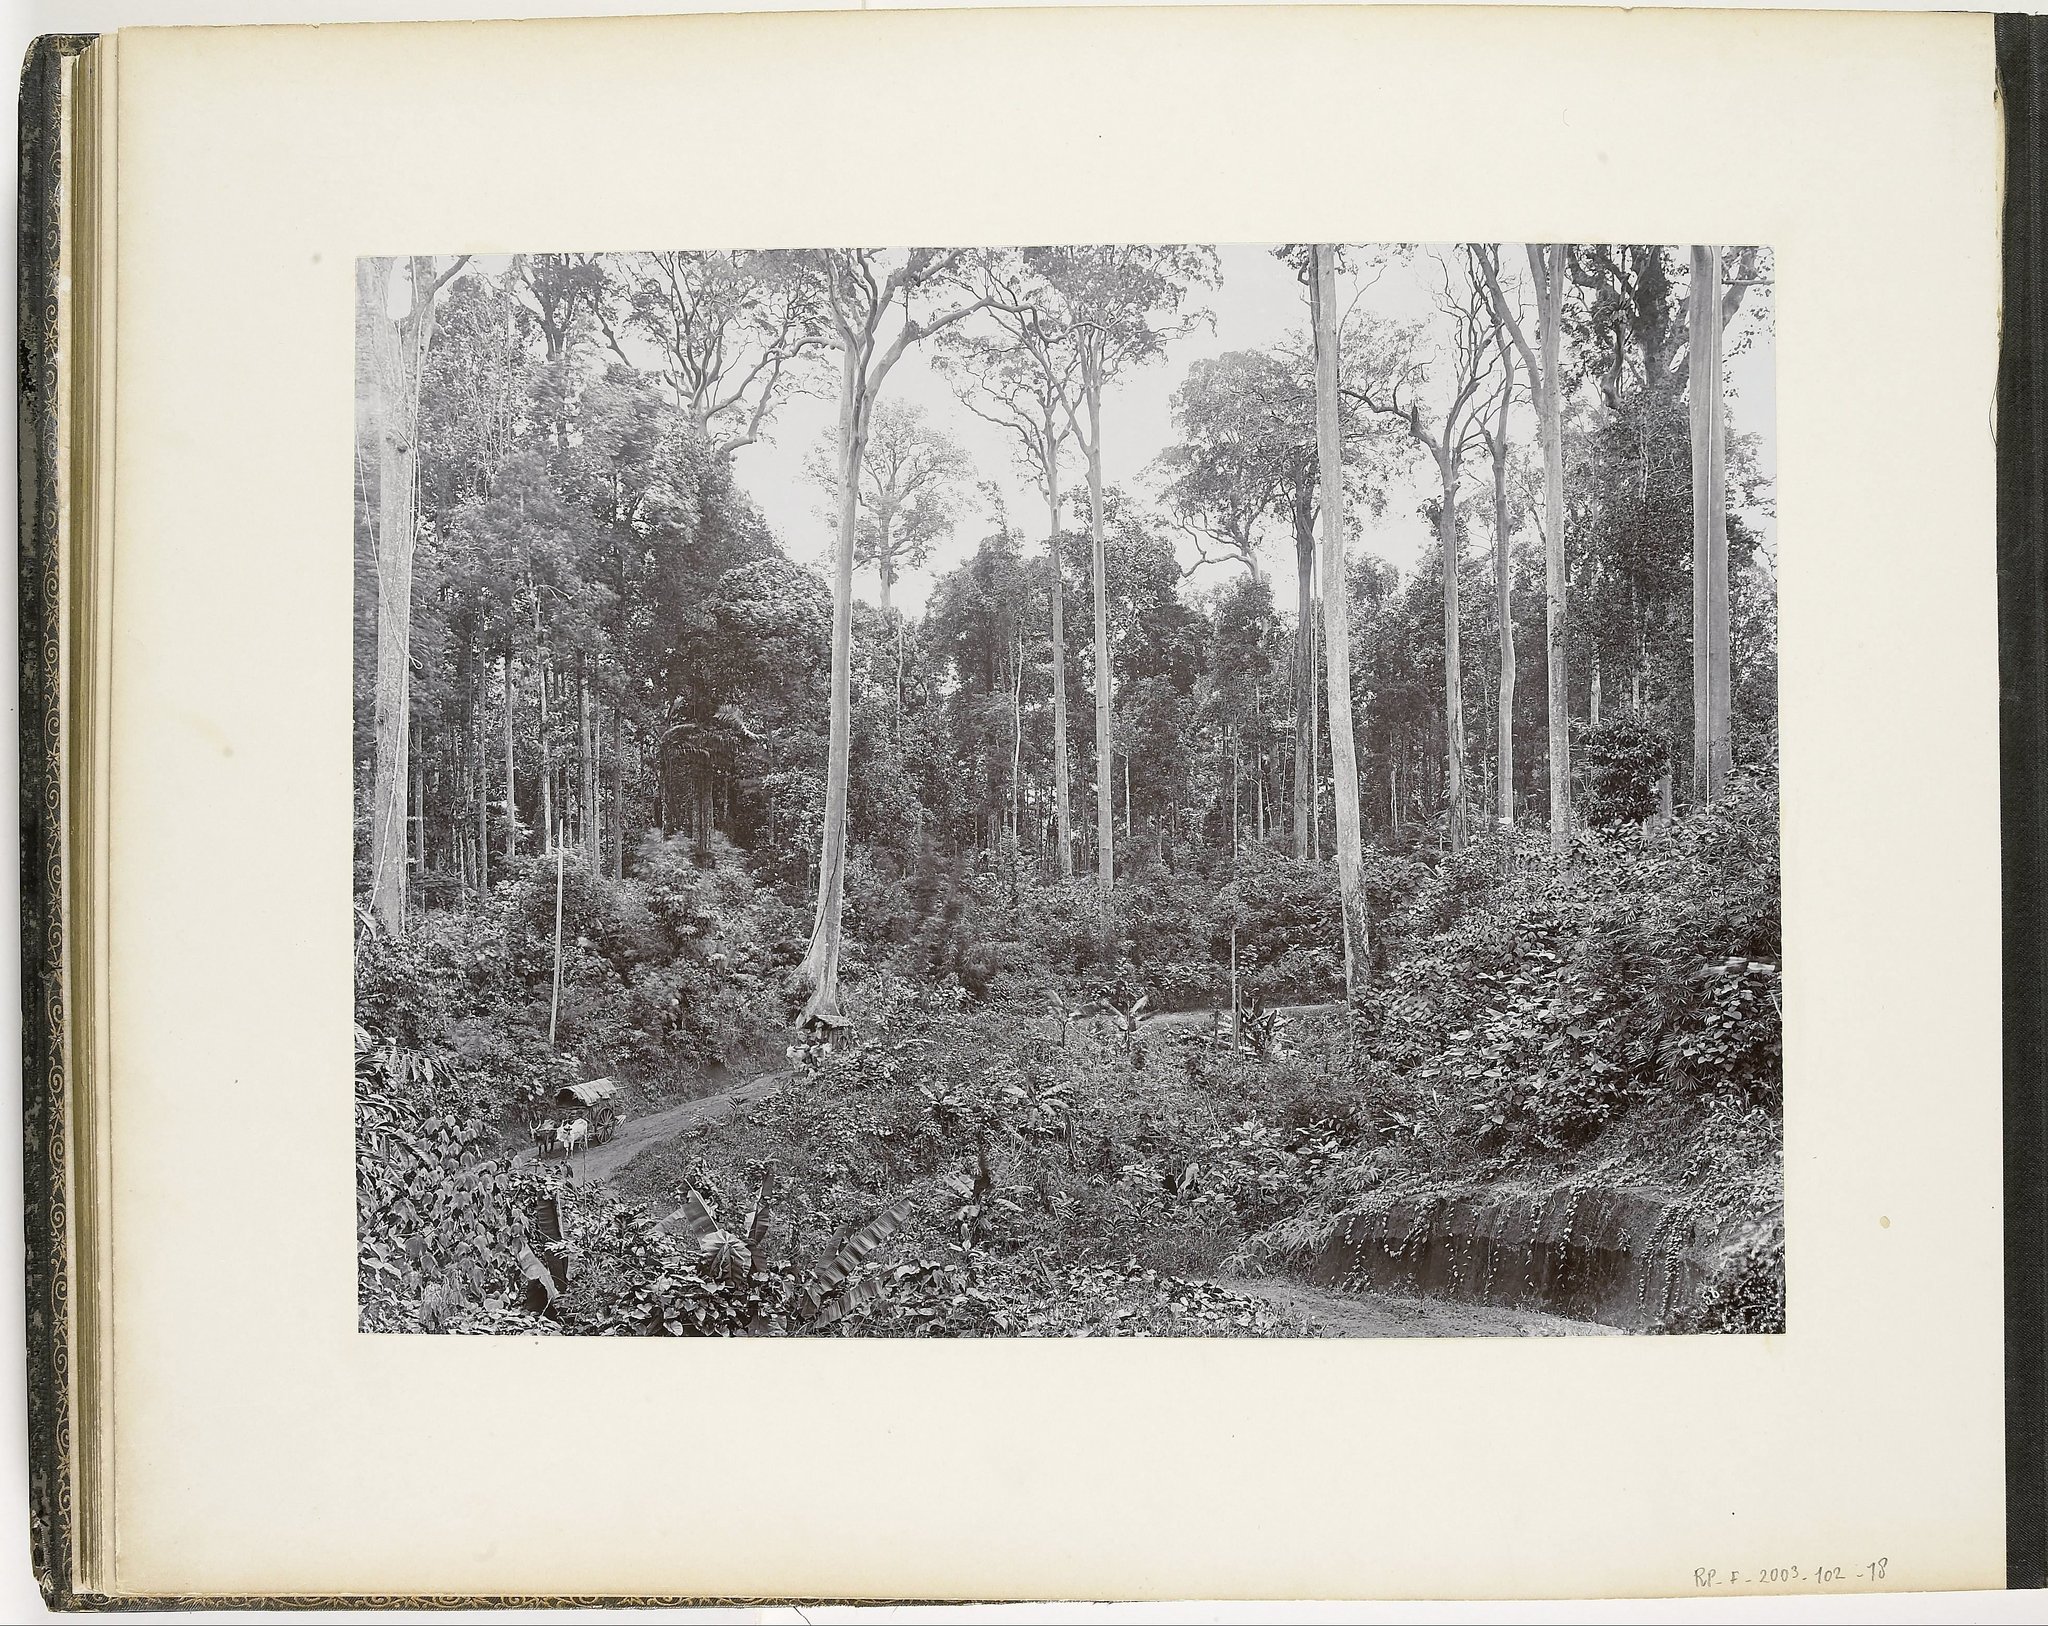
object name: photograph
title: Gezicht op een rij met hoge Toealang bomen, Rinteh Estate, Sumatra (Toealang Parthie Goenoeng Rinteh Estate)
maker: carl j. kleingrothe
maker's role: fotograaf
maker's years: 1864-1925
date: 1885-1900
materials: photographic support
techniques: collodion silver print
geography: medan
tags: sumatra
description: Gezicht op de hoge Toealang of Twalang bomen langs de weg naar de Rinteh Plantage op Sumatra. Onderdeel van het Sumatra fotoalbum van Paul en Lucie Sandel uit 1900.